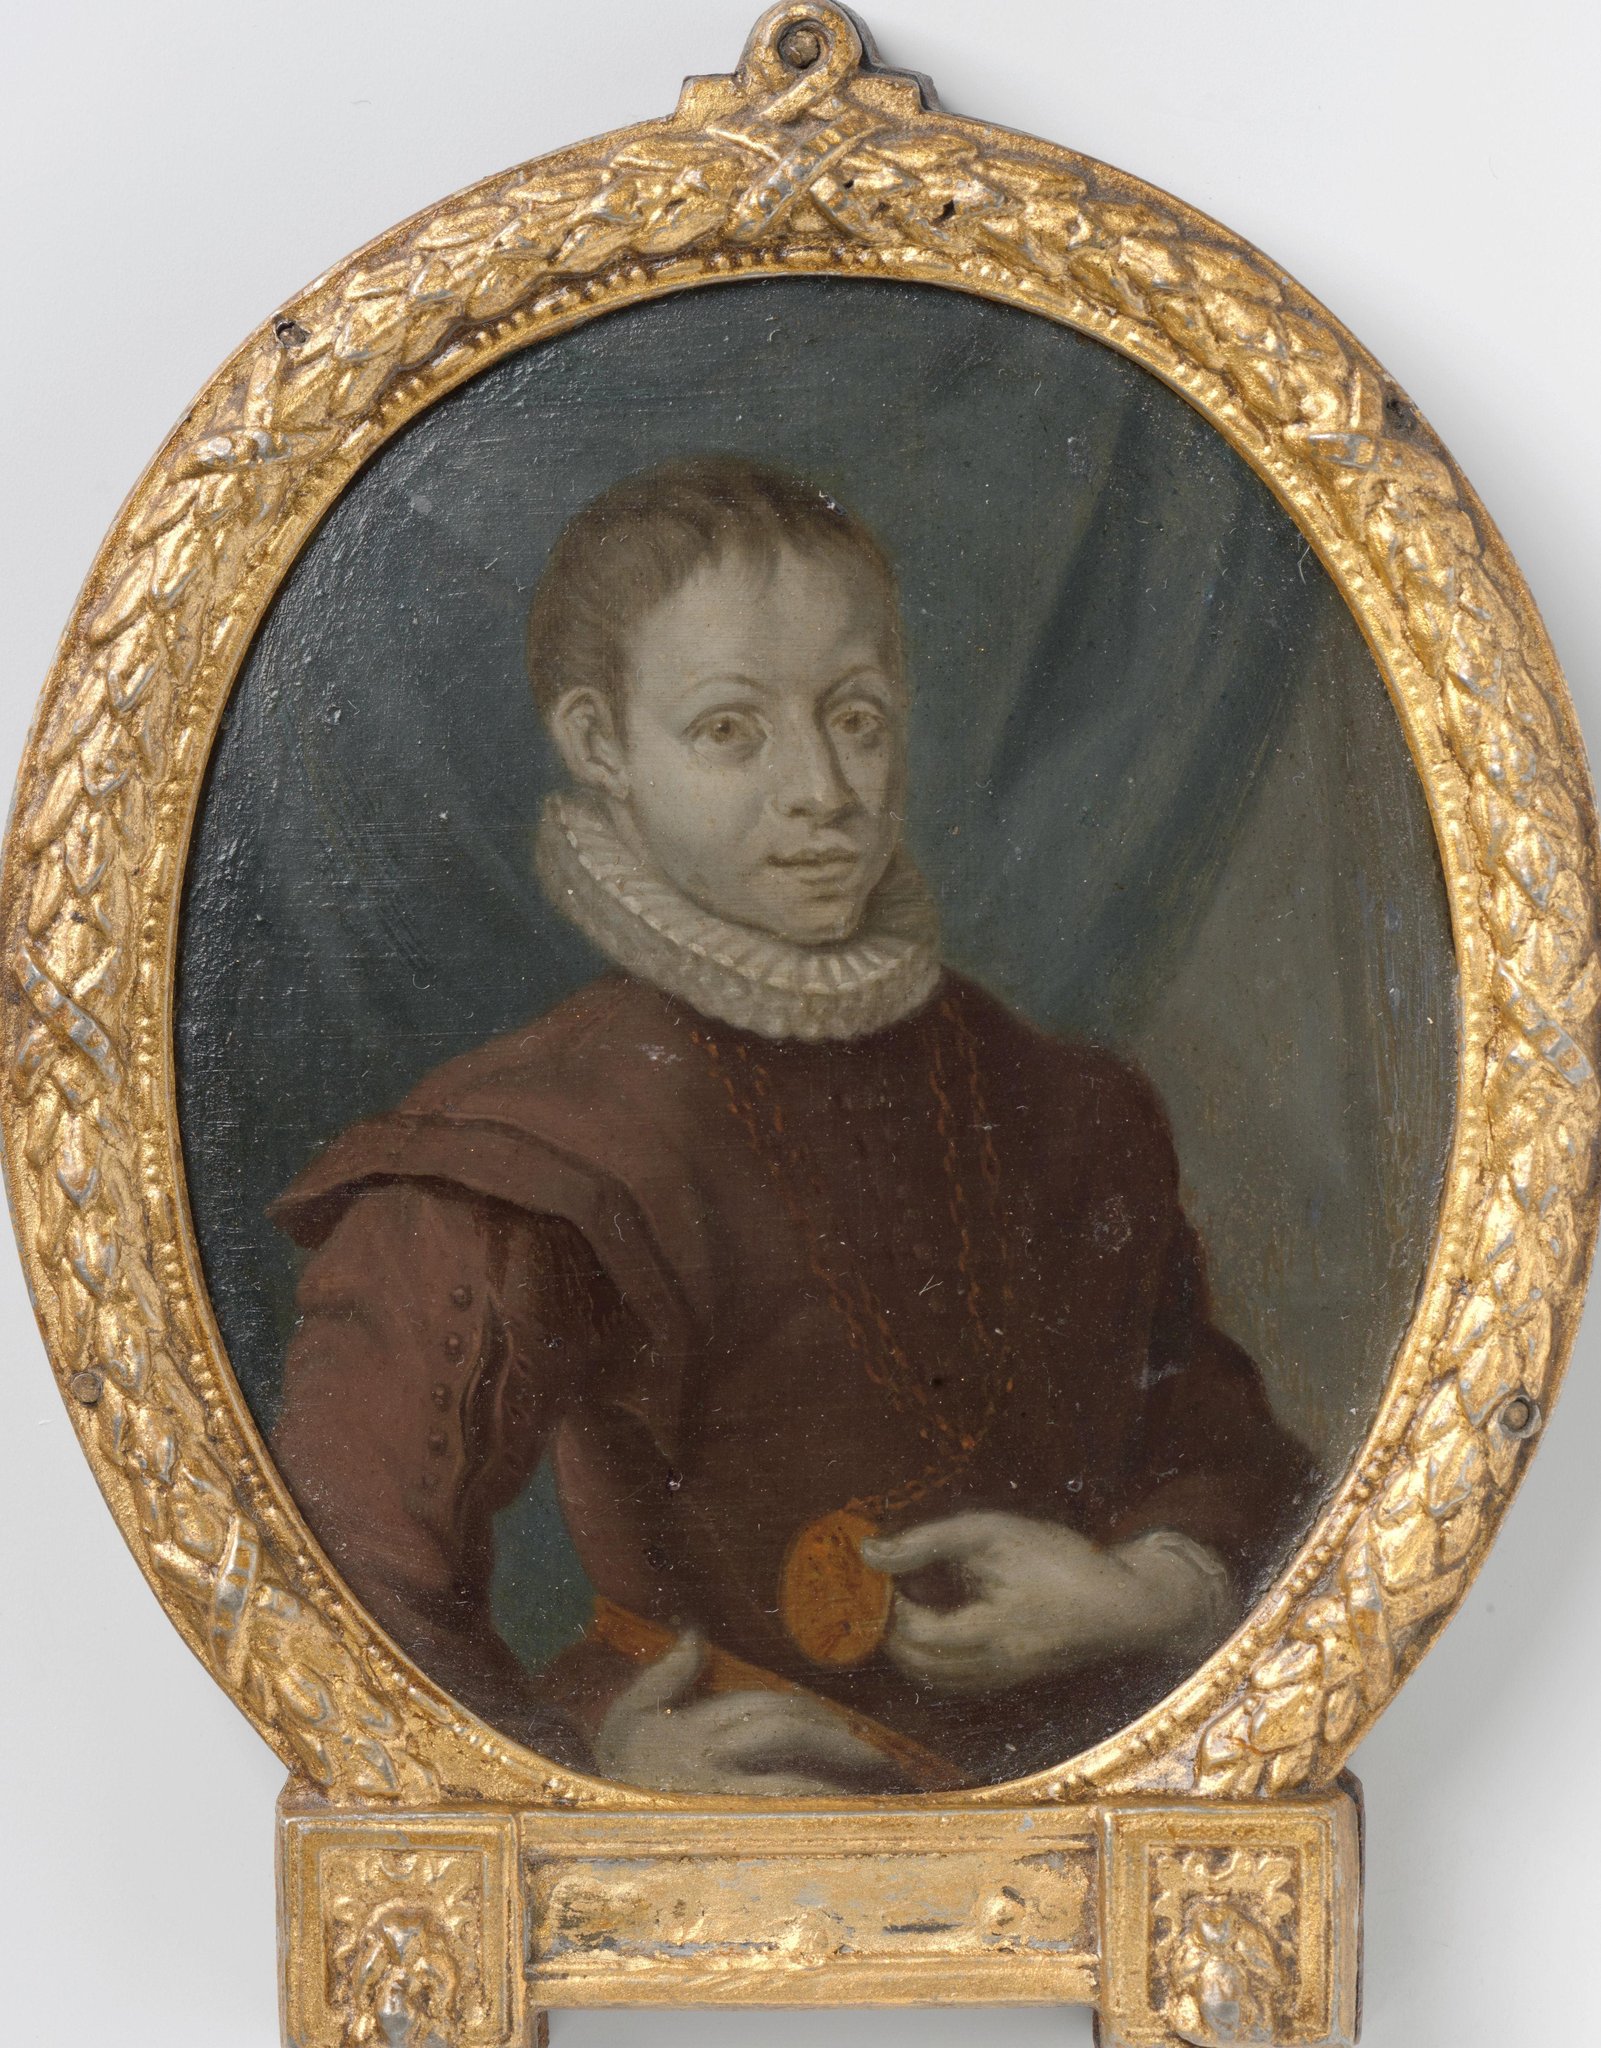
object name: painting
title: Hugo de Groot op jonge leeftijd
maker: arnoud van halen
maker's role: draughtsman, painter, print maker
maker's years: 1673-1732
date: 1710-1719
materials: oil, paint, tin, wood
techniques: gilding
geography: amsterdam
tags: delft, hugo de groot, historical persons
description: Hoewel op de achterzijde een kleine sticker met de naam Henri IV is aangebracht, betreft het hier een buste van Hugo de Groot als 15-jarige jongeman. Hij is van rechts in driekwartprofiel gezien en gezeten met zijn rechterhand in de zij, de elleboog naar de beschouwer gedraaid. Het wonderkind Hugo de Groot had in 1599 al een universitaire studie achter de rug: tijdens zijn verblijf in Frankrijk in 1598 was hij in de rechten gepromoveerd. Koning Hendrik IV schonk hem bij deze gelegenheid een medaillon met een portret van de koning zelf, dat De Groot hier in de linkerhand houdt. Dit medaillon heeft waarschijnlijk aanleiding gegeven tot de verkeerde identificatie. De identificatie als Hugo de Groot op jongere leeftijd is gebaseerd op een portretgravure van Jacob de Gheyn (II) uit 1599, zie collectie Rijksmuseum, RP-P-OB-9953 en op het feit dat in vroege beschrijvingen van het Panpoëticon Batavum sprake is van een portret van Hugo de Groot op jonge leeftijd.